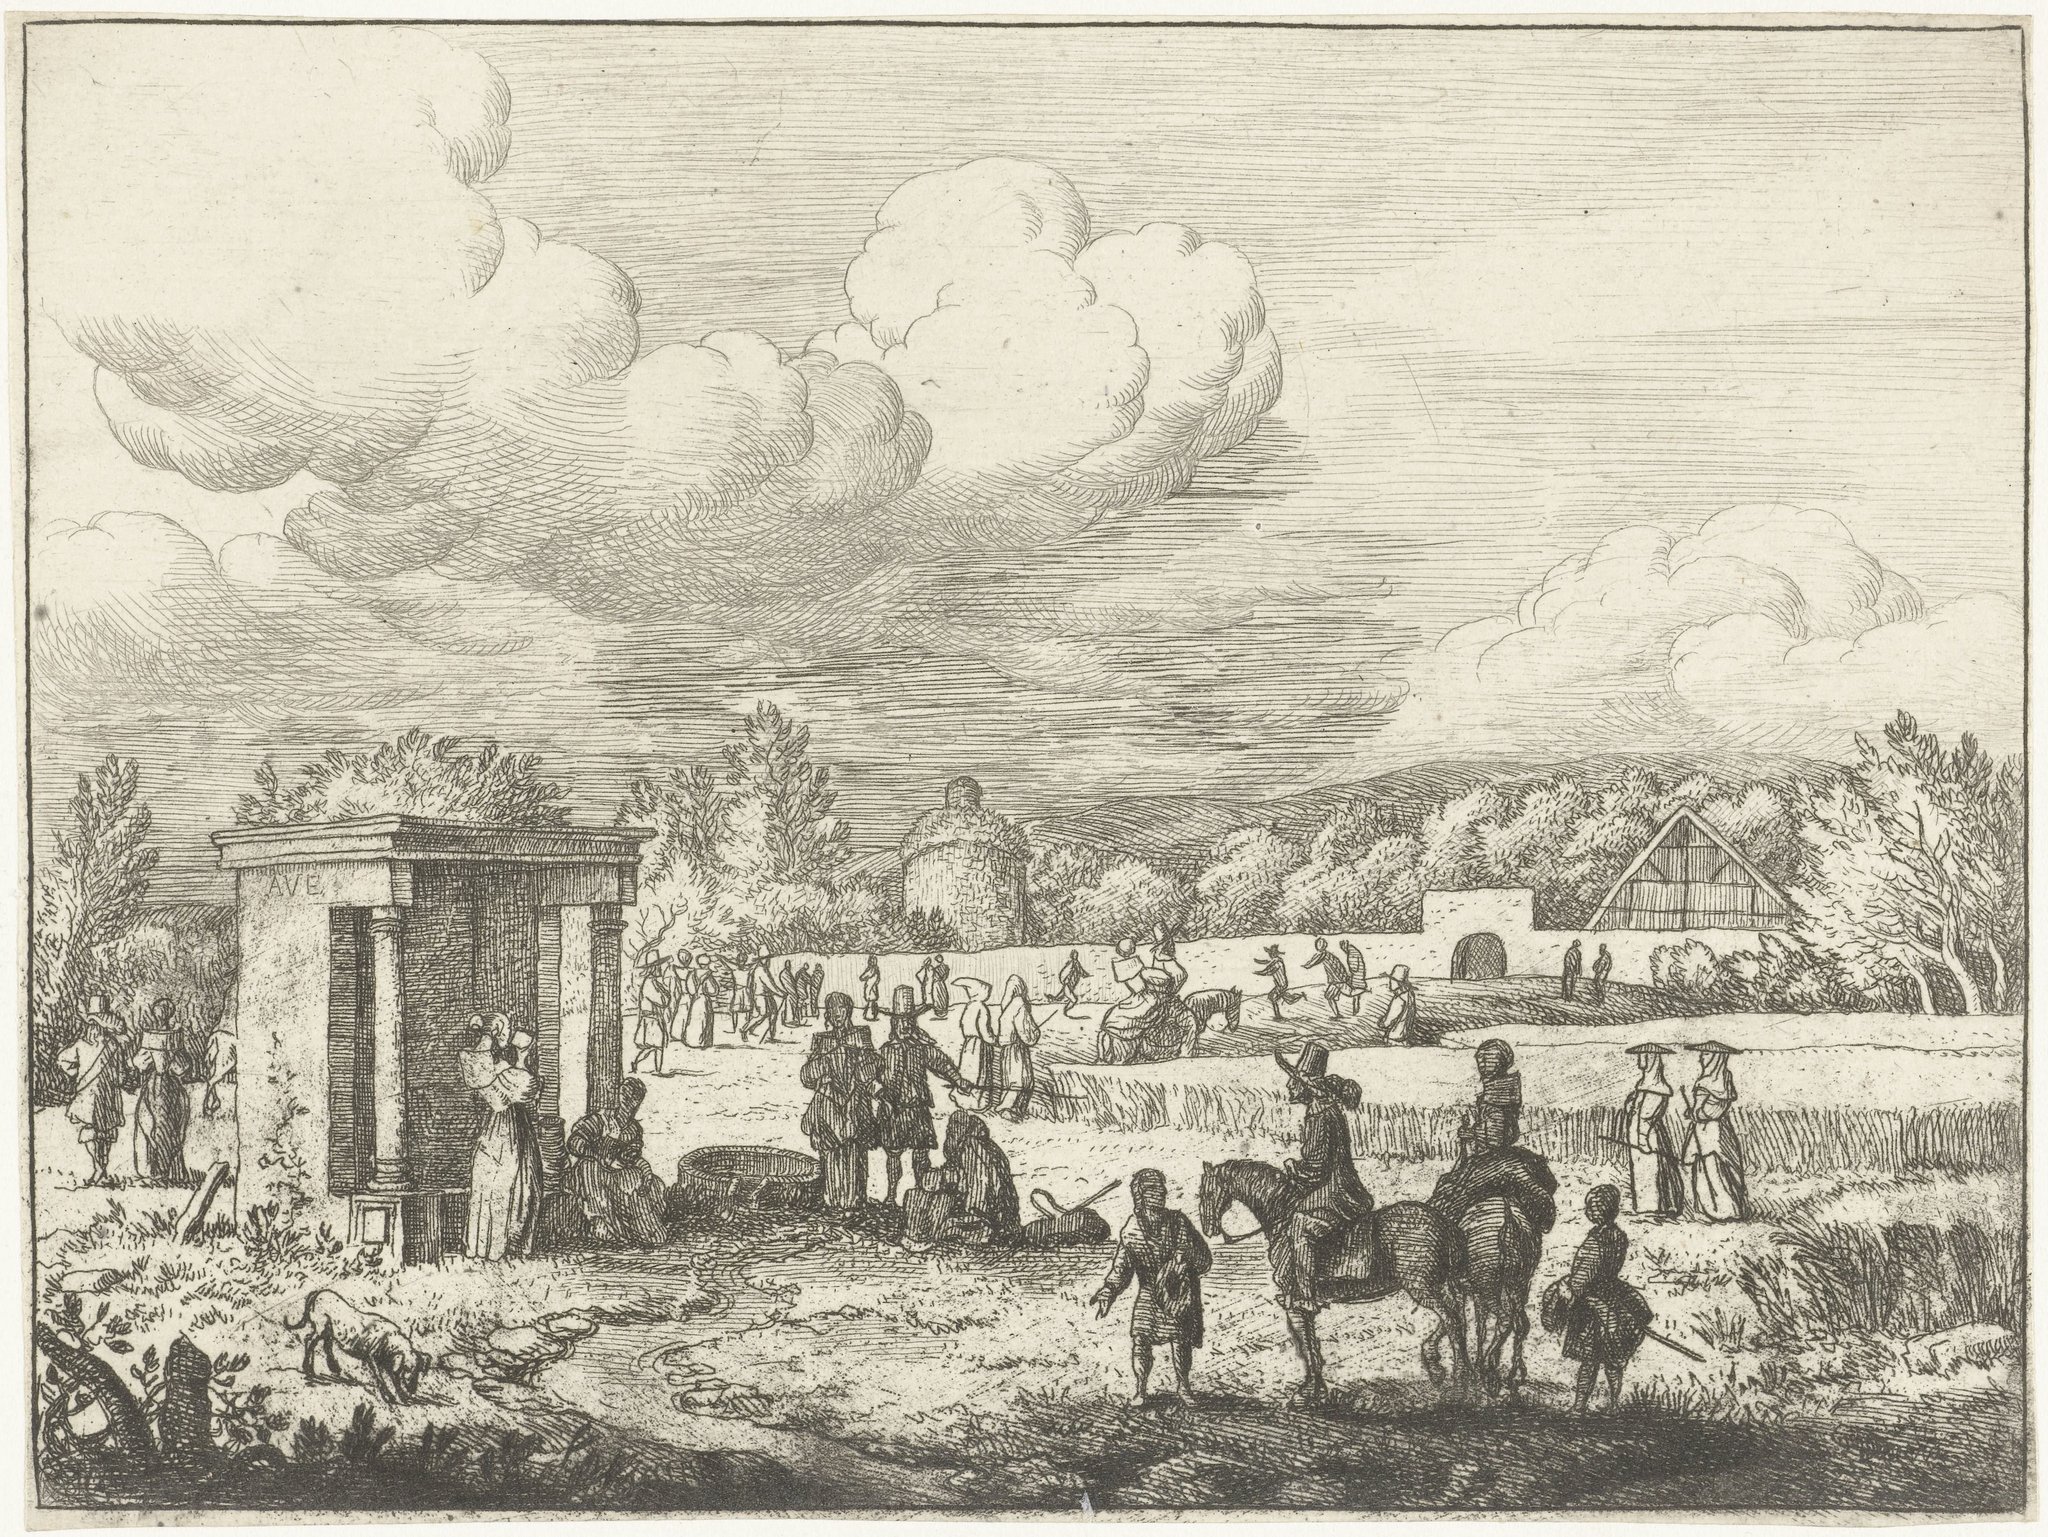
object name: print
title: Vier waterbronnen in en rond Spa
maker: allaert van everdingen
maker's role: draughtsman, painter, print maker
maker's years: 1621-1675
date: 1631-1675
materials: paper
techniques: etching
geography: netherlands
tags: spring (fluids extracted from the earth)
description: Een landschap met een korenveld en verschillende personen in voet en te paard. Op de voorgrond twee ruiters en twee staande personen bij een stroompje afkomstig uit een waterbron.